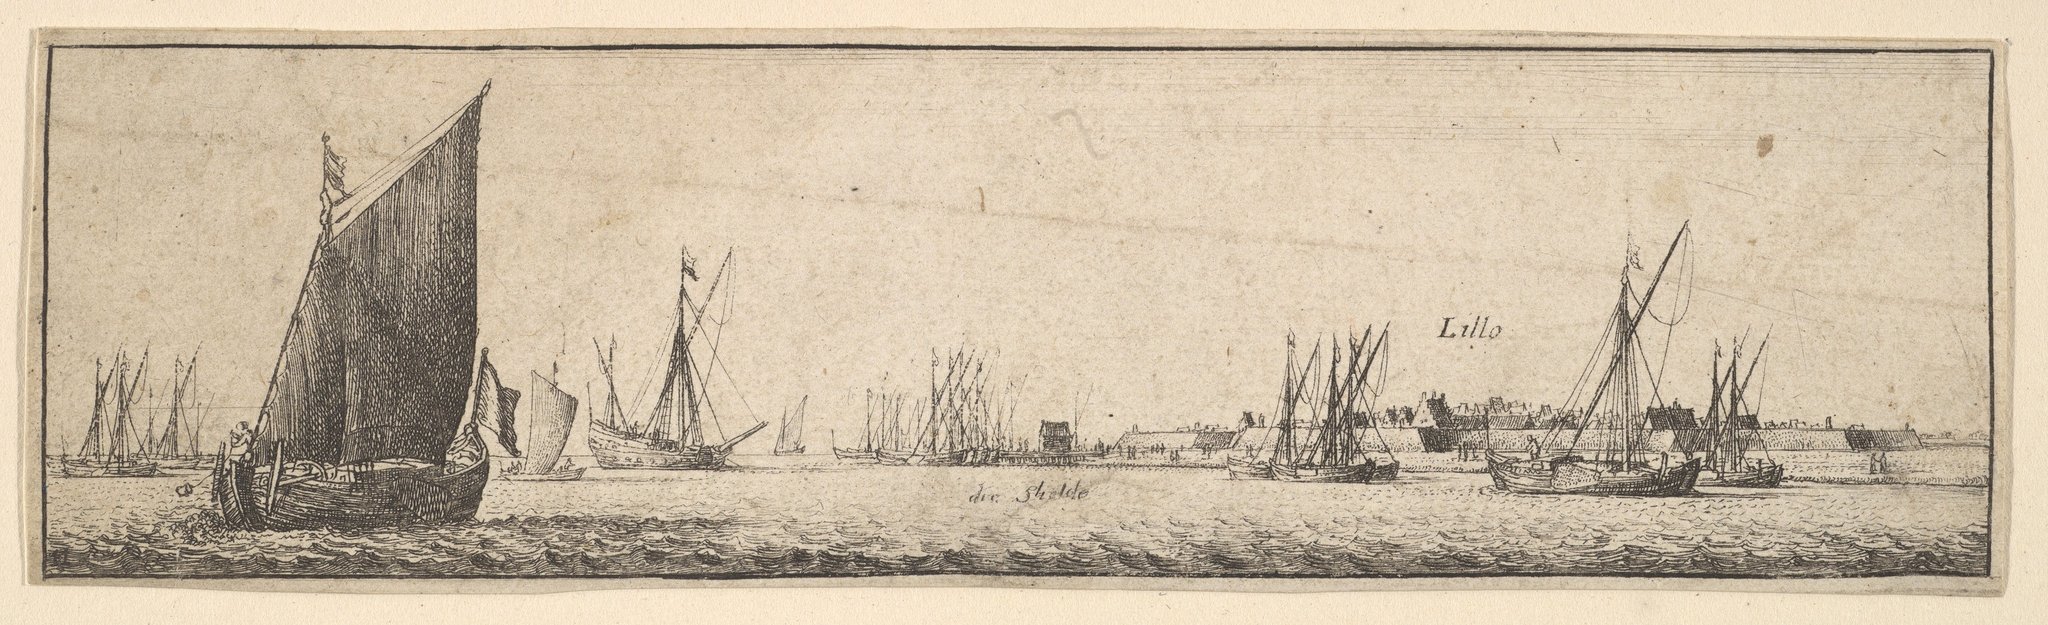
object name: print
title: Lillo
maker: wenceslaus hollar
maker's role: artist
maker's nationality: bohemian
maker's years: 1607-1677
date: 1642-1644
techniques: etching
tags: rivers,boats